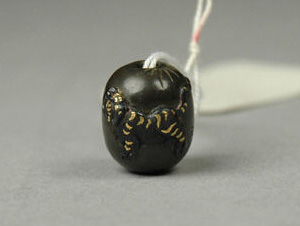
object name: ojime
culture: japanese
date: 1801-1900